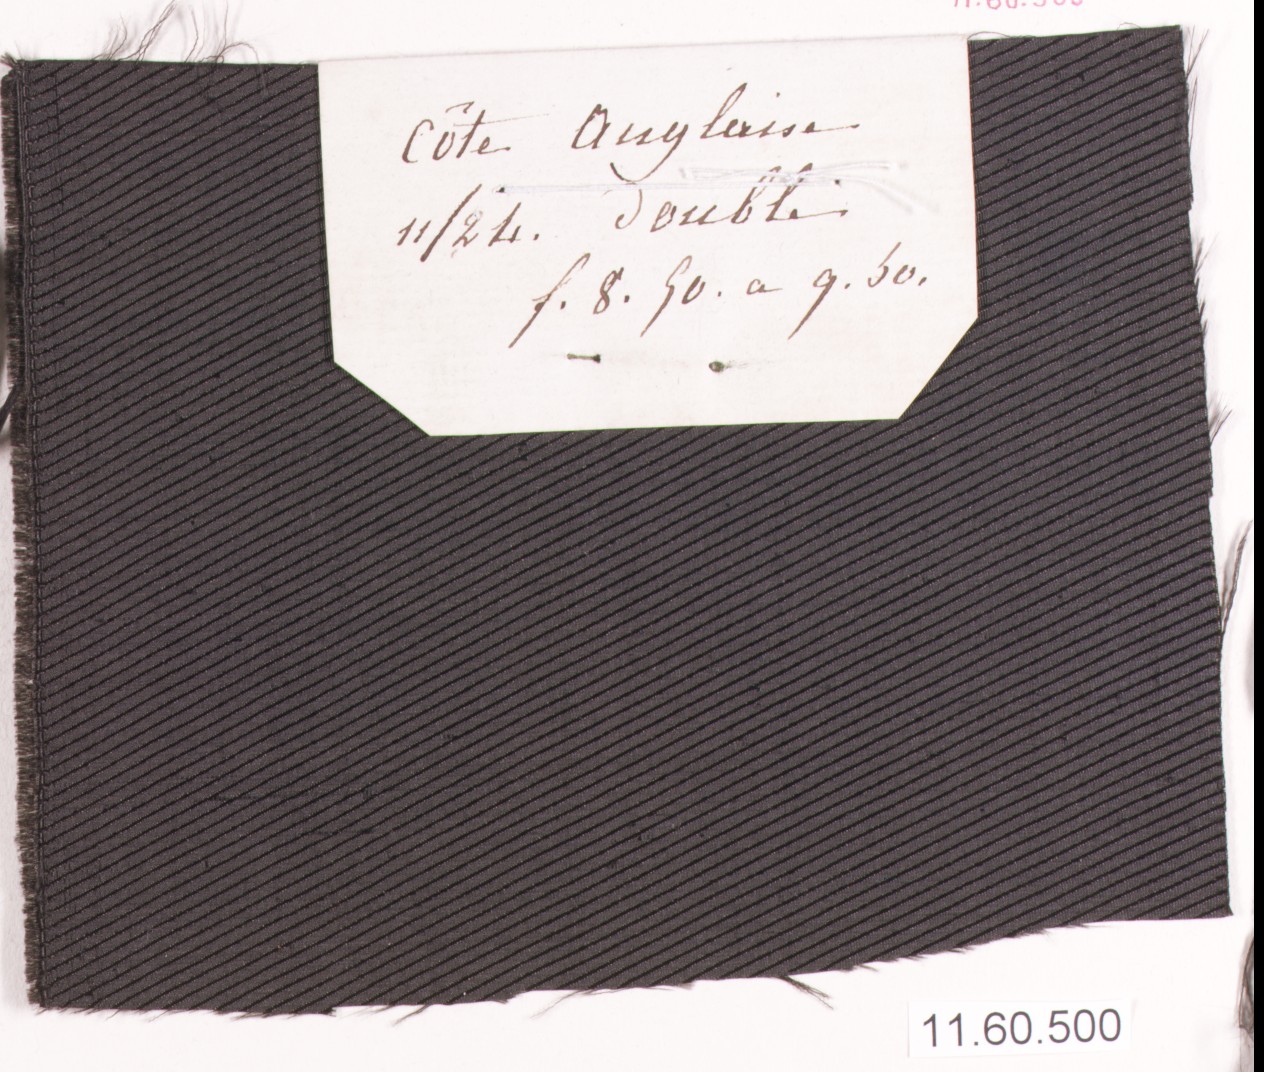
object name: sample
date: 1801-1850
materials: silk